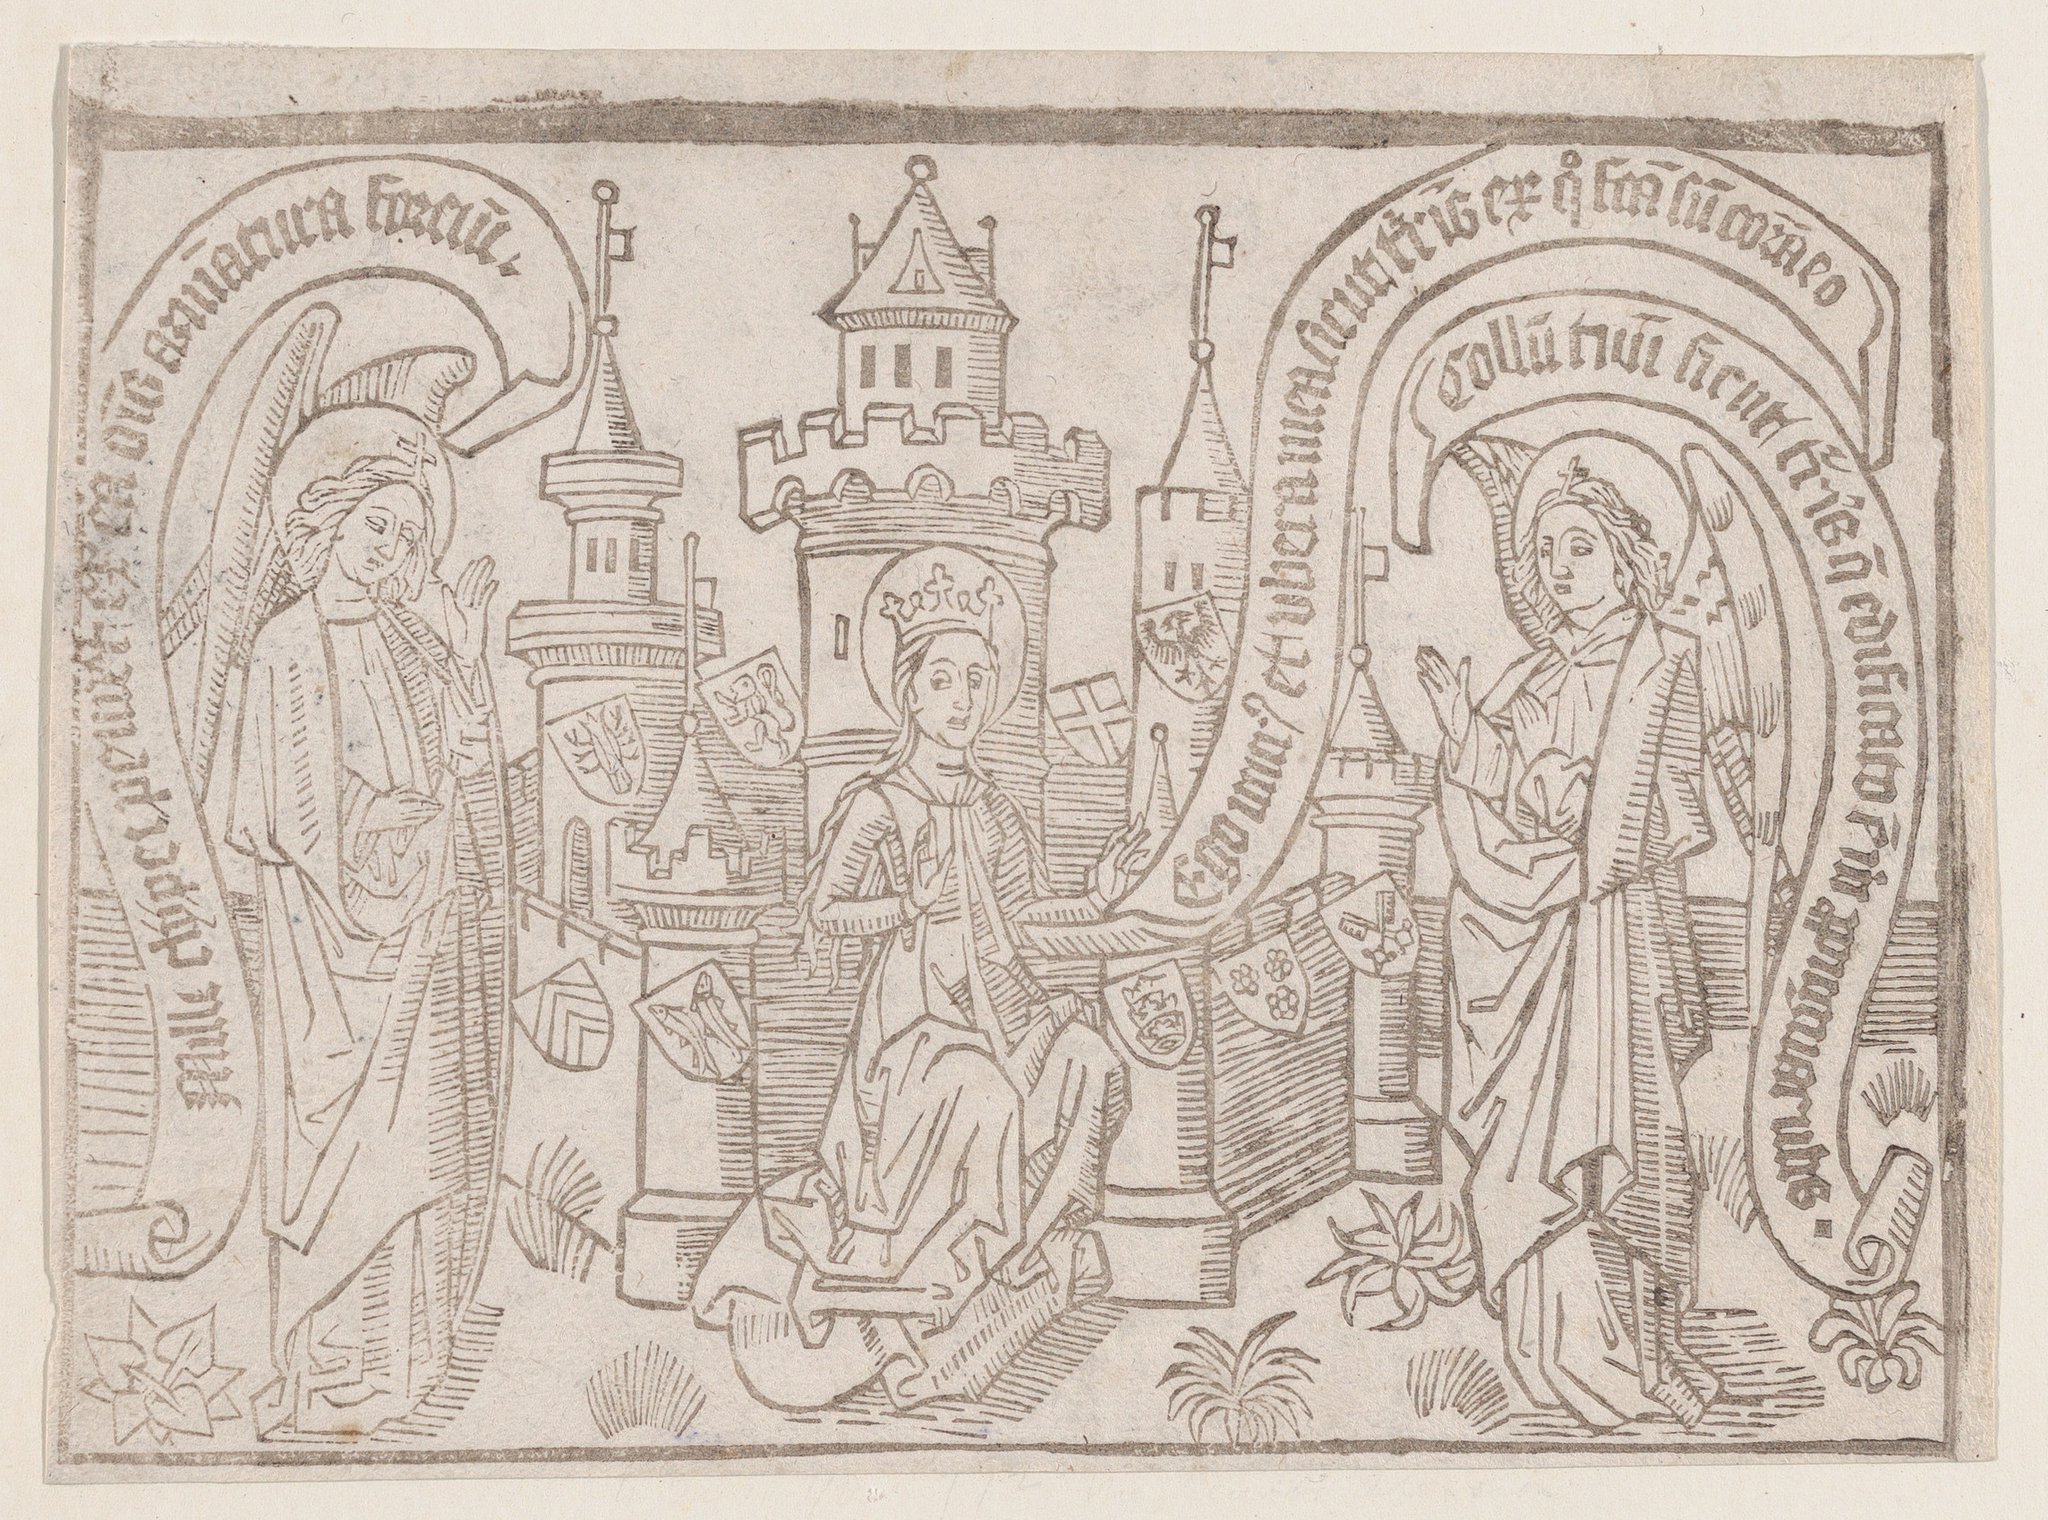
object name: print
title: Thy Neck Is Like the Tower of David, illustration from a Canticum Canticorum blockbook, 2nd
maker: anonymous, netherlandish, 15th century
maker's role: artist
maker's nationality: netherlandish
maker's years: 1400-1500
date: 1460-1465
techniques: printing, woodcut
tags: buildings,women